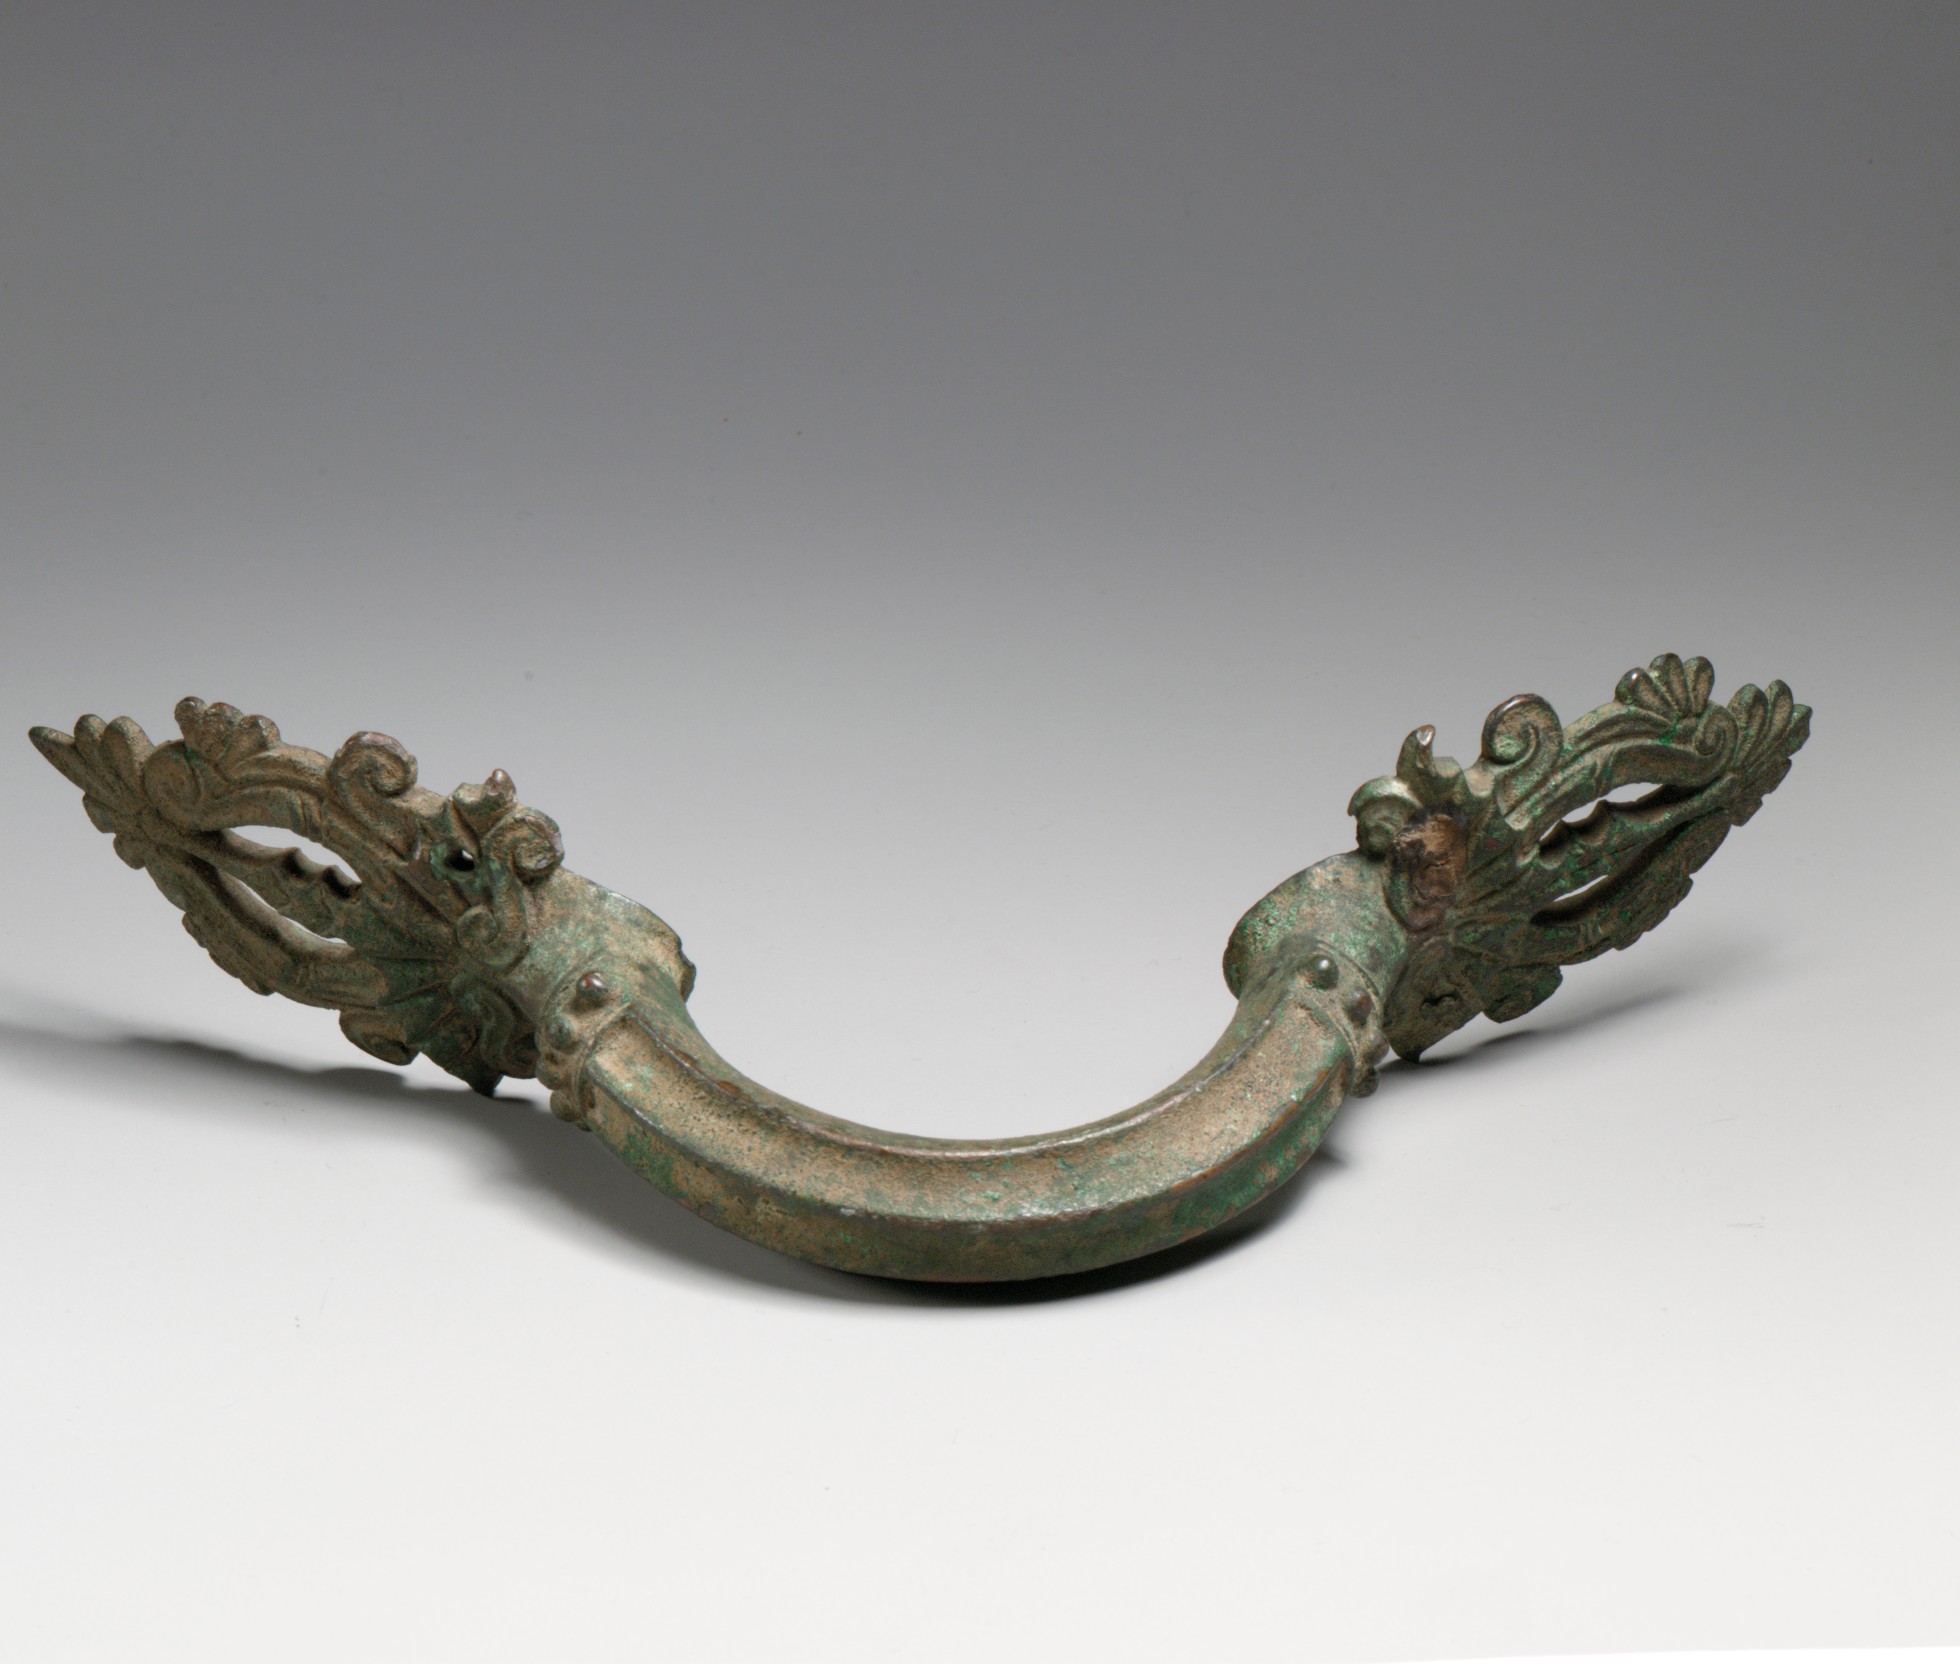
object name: handle of a hydria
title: Bronze handle of a hydria (water jar)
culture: greek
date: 400-301 BCE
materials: bronze